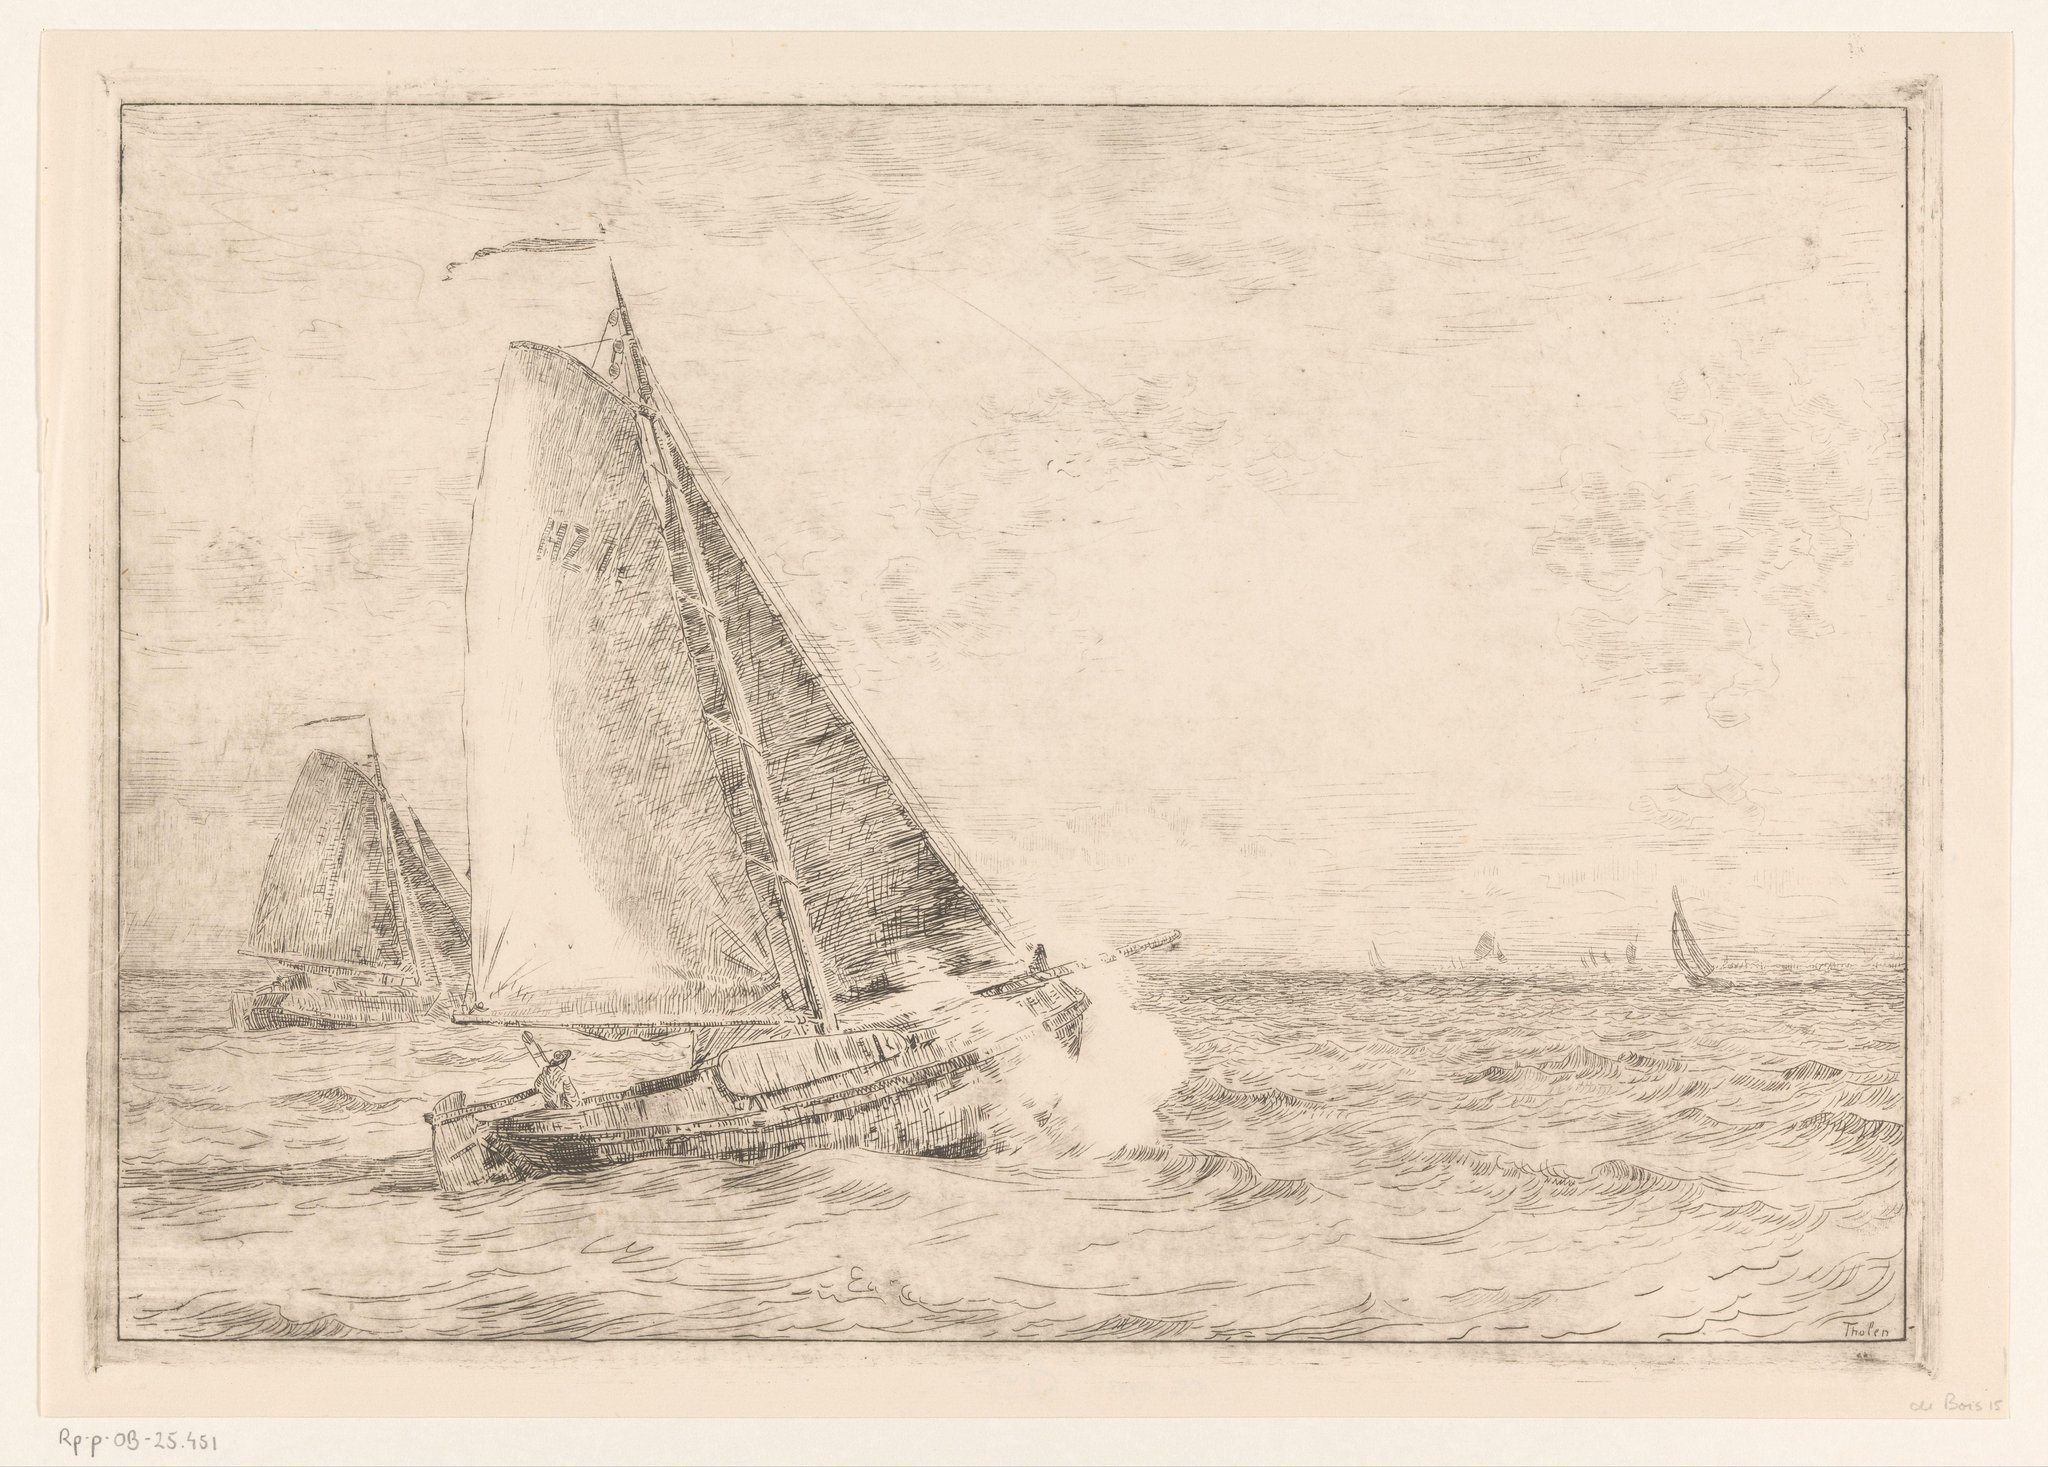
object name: print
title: Zeilboten op open water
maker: willem bastiaan tholen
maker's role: draughtsman, painter, print maker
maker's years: 1860-1931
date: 1870-1909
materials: paper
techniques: etching, intaglio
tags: sailing-ship, sailing-boat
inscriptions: collector's mark: Lugt 2228